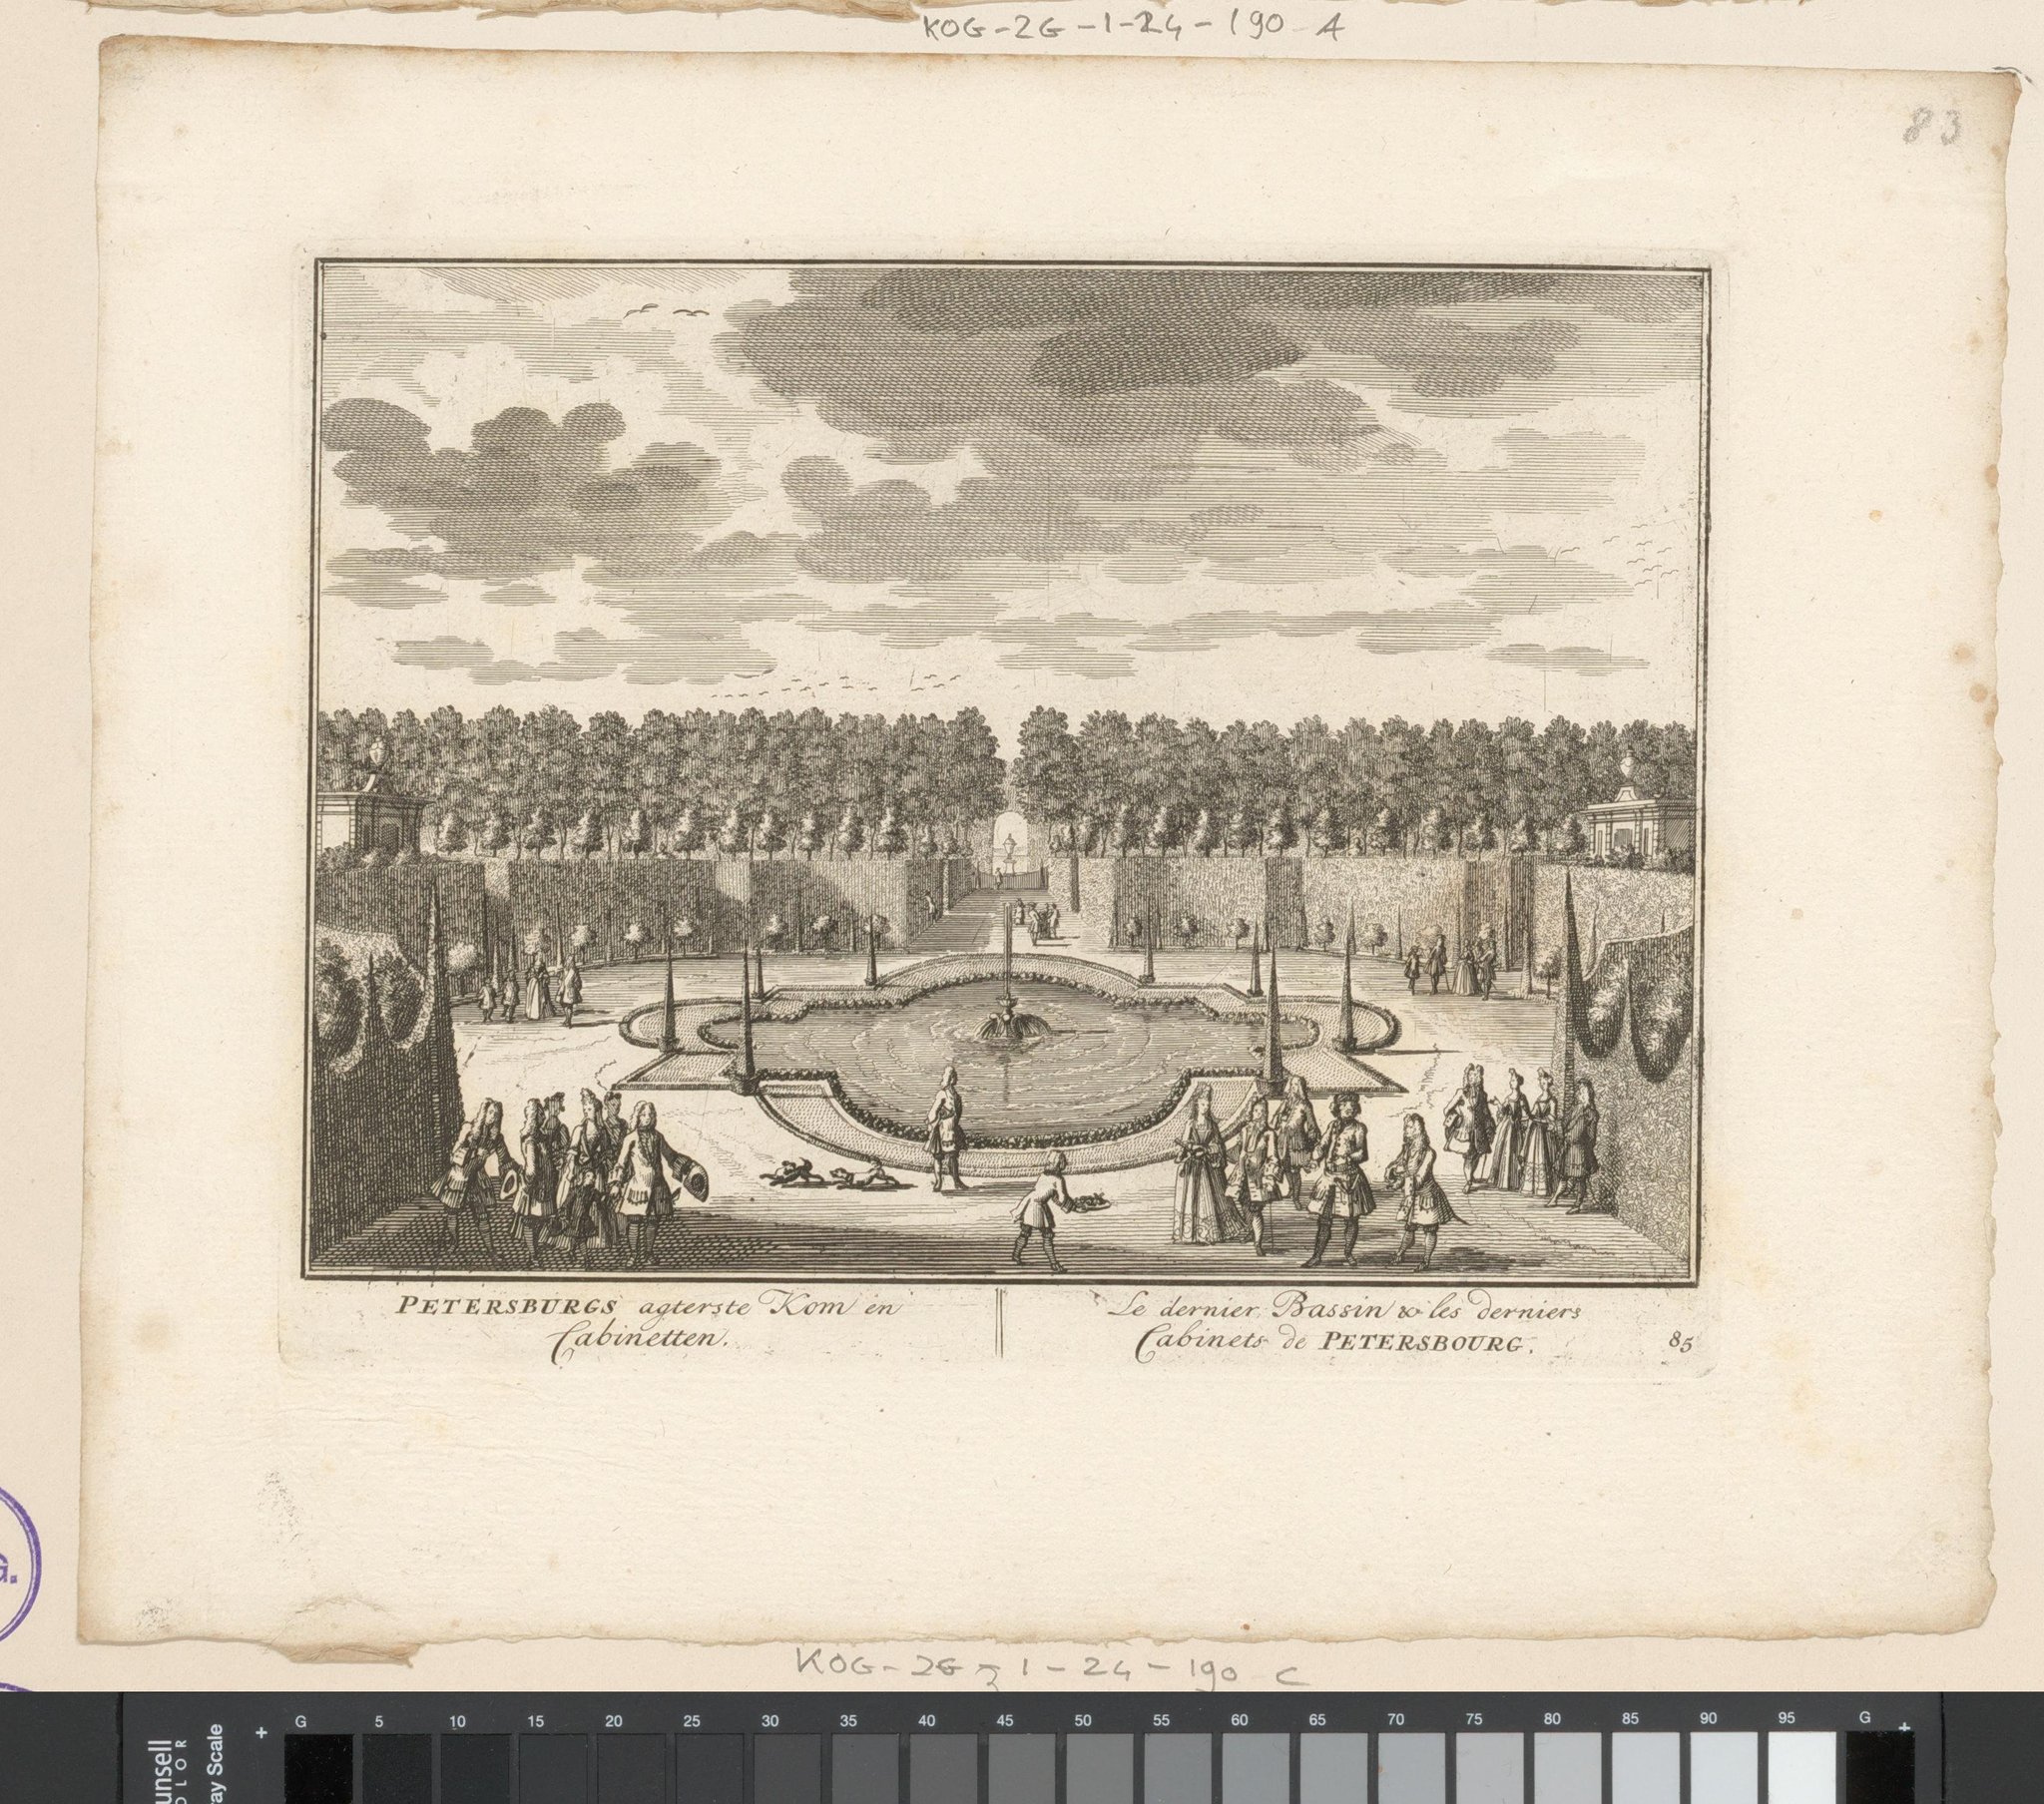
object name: print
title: Petersburgs agterste Kom en Cabinetten / Le dernier Bassin & les derniers Cabinets de Petersbourg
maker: hendrik de leth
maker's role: draughtsman, print maker, publisher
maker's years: 1703-1766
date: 1729-1732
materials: paper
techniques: engraving, etching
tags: french or architectonic garden; formal garden, garden pond, country-house, nederhorst den berg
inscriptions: stamp, collector's mark: Lugt 1641, stamp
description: Prent mogelijk uit: Brouërius van Nidek, Matthaeus. Het zegepralend Kennemerland, vertoond in 100 heerlyke gezichten. Amsterdam: Jan Roman, s.a. Of uit: Brouërius van Nidek, Matthaeus. Het zegepralend Kennemerland, vertoond in veele heerlyke gezichten. Amsterdam: Andries en Hendrik de Leth, s.a [1729-1732]. Of uit: Brouërius van Nidek, Matthaeus. Het zegepralend Kennemerland, vertoond in veele heerlyke gezichten. Amsterdam: Jan Roman, s.a.